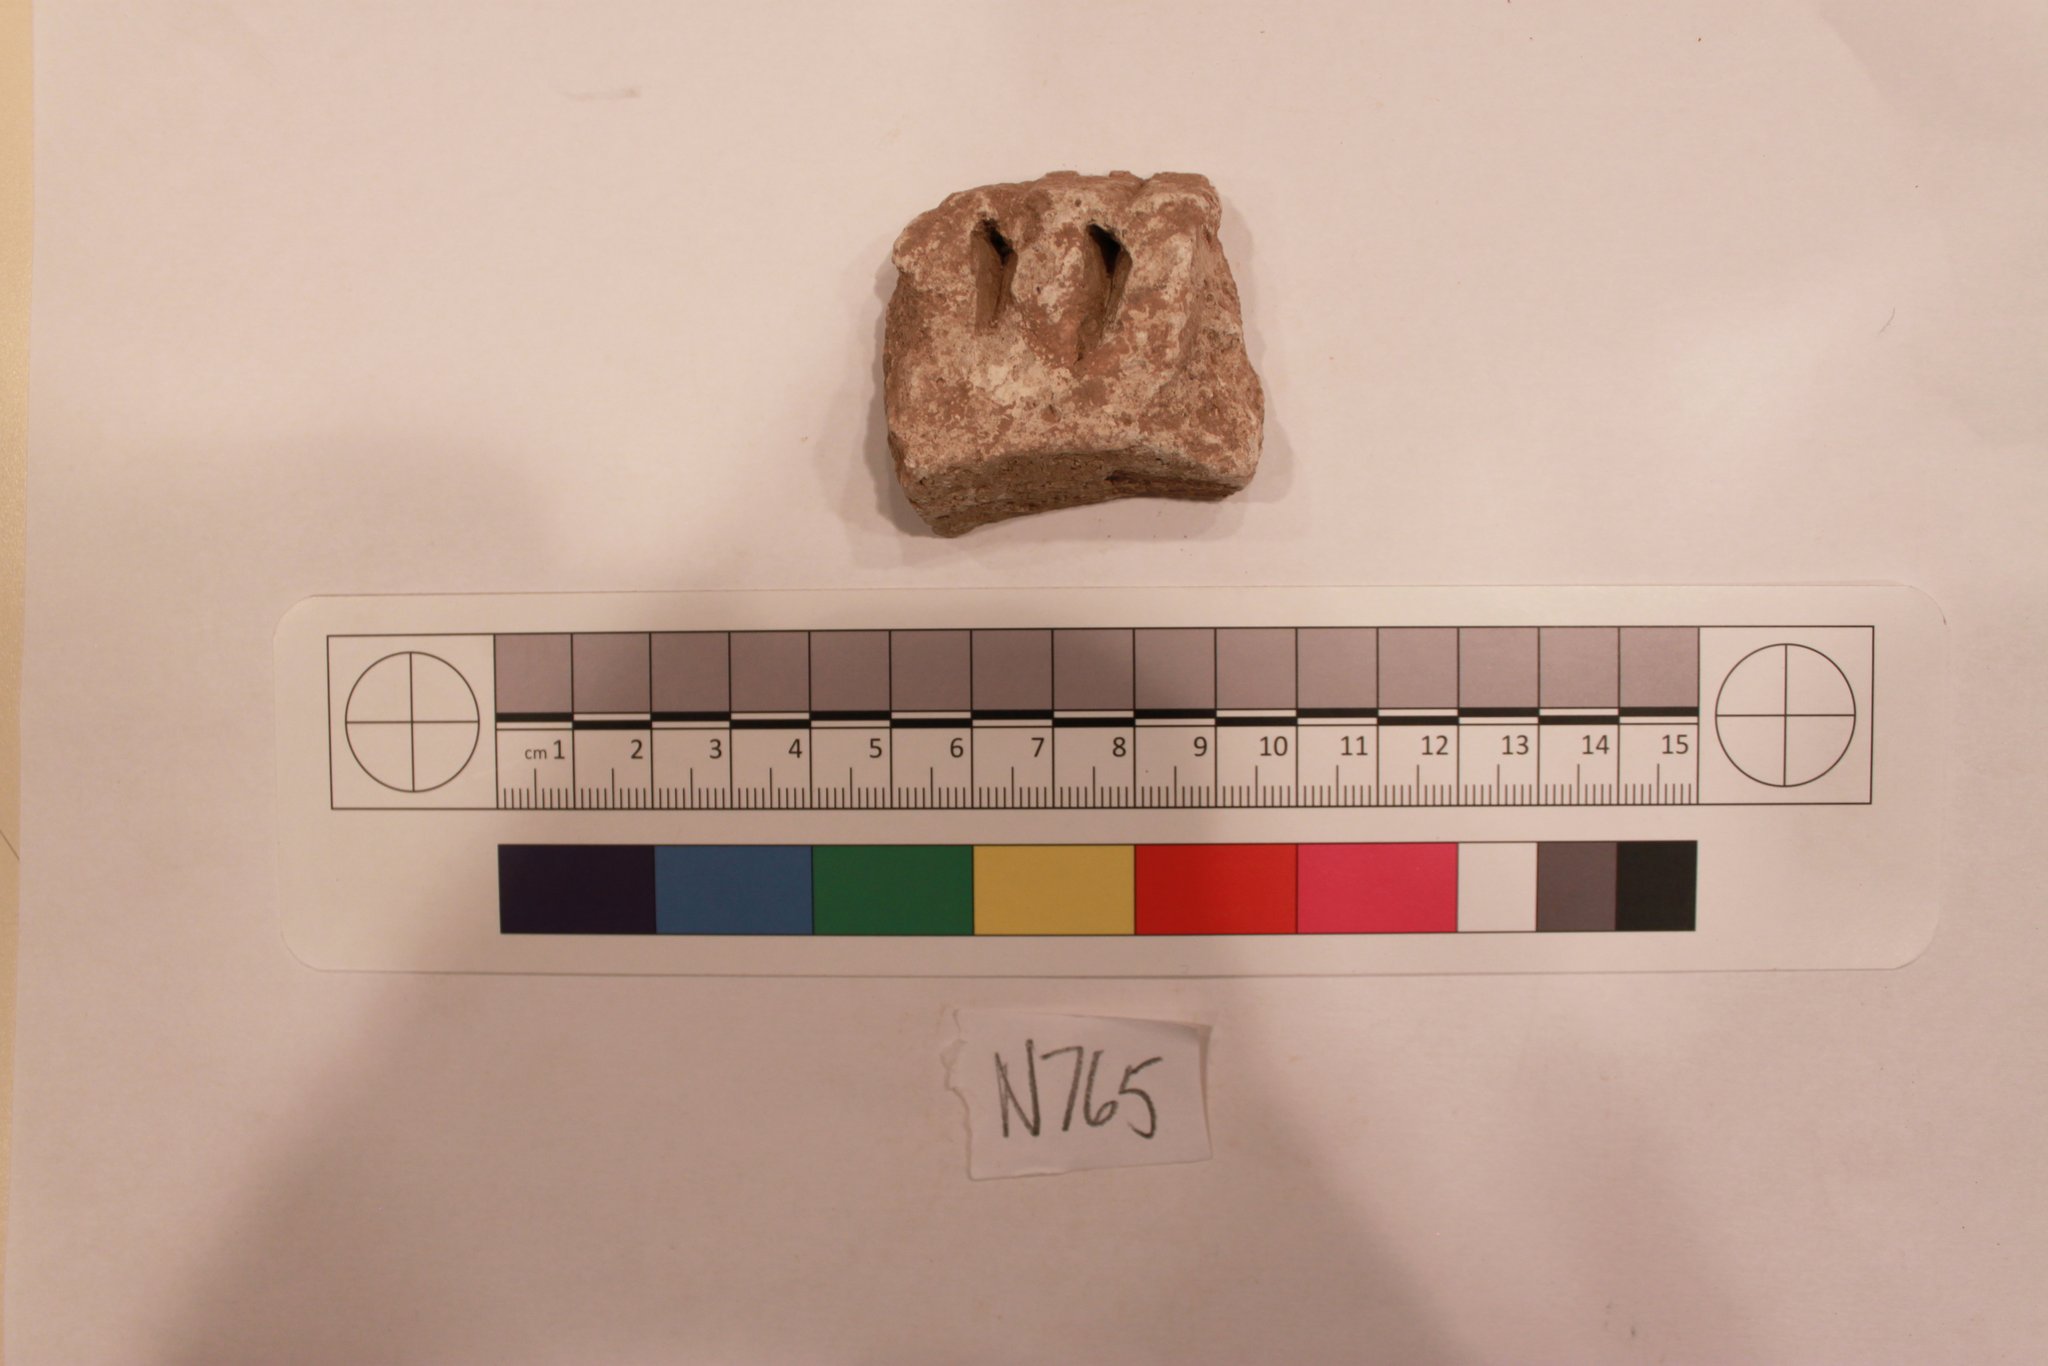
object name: fragment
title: Stucco Fragment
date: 701-1200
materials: plaster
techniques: carving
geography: iran